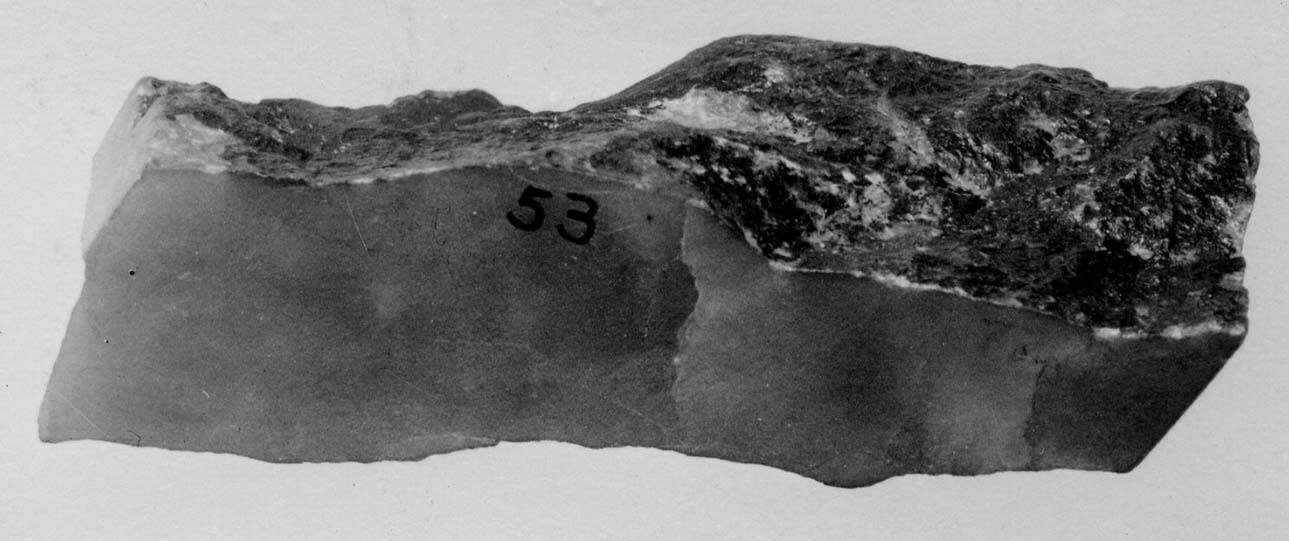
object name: fragment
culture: tibetan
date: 1902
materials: jade